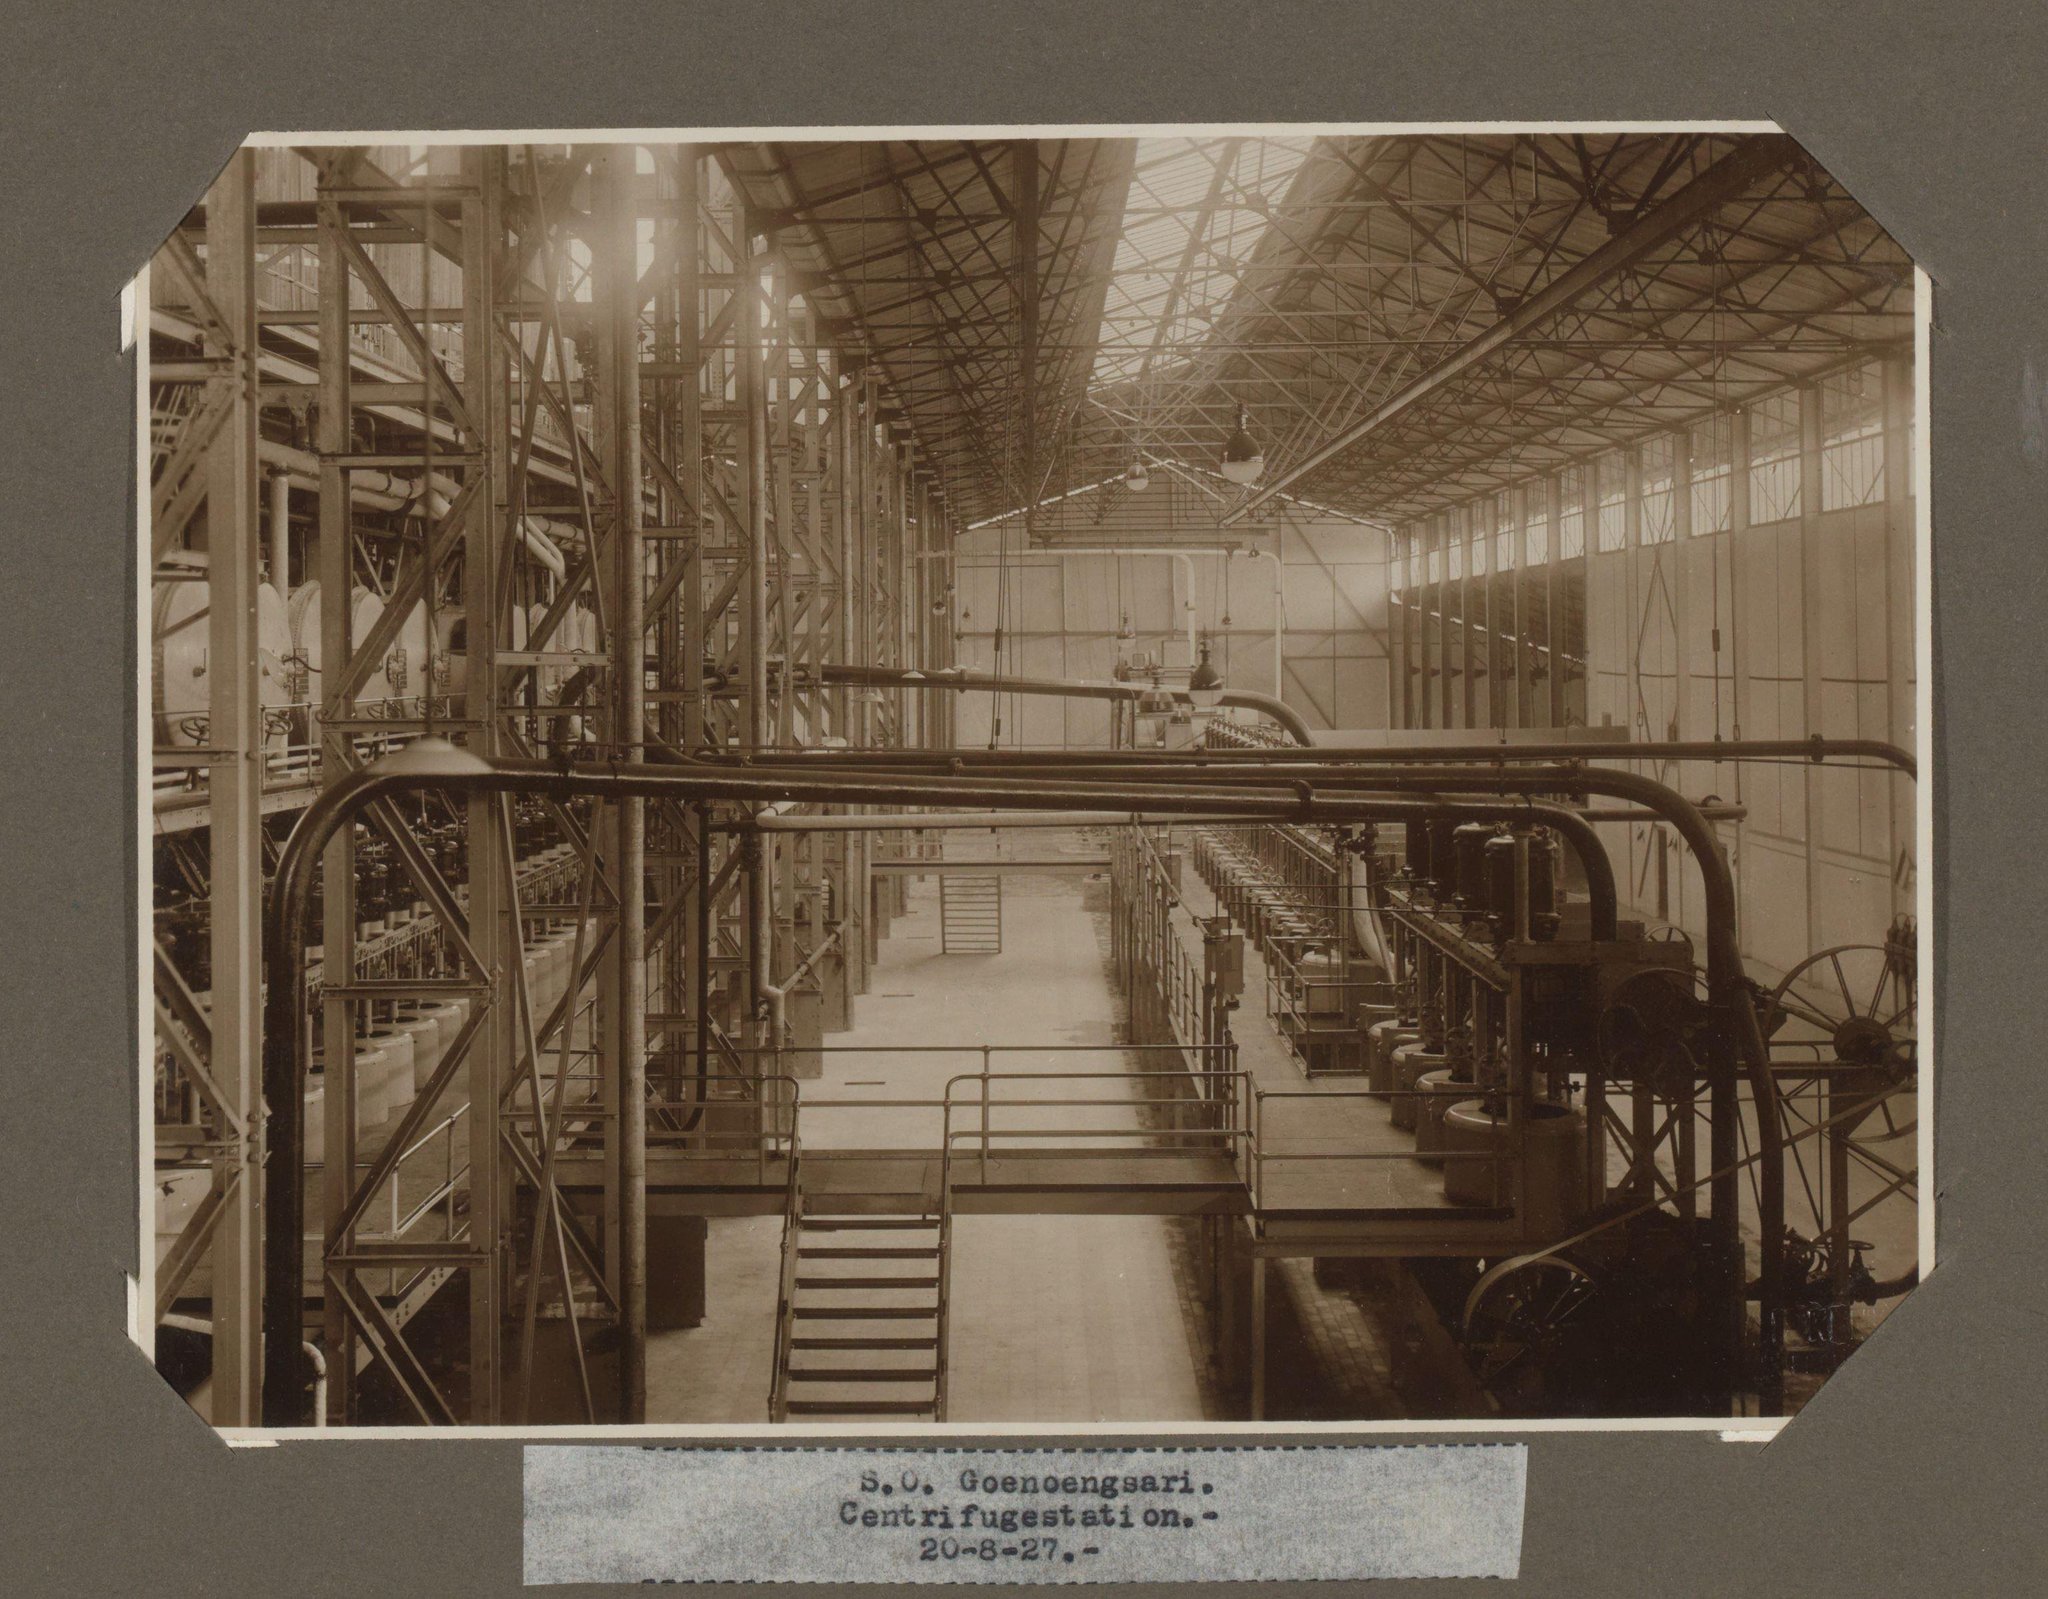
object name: photograph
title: S.O. Goenoengsari. Centrifugestation. 20-8-27.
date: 1908-1927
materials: photographic support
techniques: gelatin silver print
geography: surabaya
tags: colonial system, trade-company, factory-interior, machine shop, making the overground structures (~ building activities), (non-fruit) products of plants or trees: sugarcane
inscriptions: company name: ‘"ISKEN" Soerabaia’, inscription: ‘S.O. Goenoengsari. Centrifugestation. 20-8-27.’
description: Fabriekshal met installaties. Bouw voltooid, eind augustus 1927. Onderdeel van het fotoalbum met foto's van de opbouw van de suikerfabriek te Goenoengsari op Oost-Java door de Handels Vereniging Amsterdam 1926-1927.